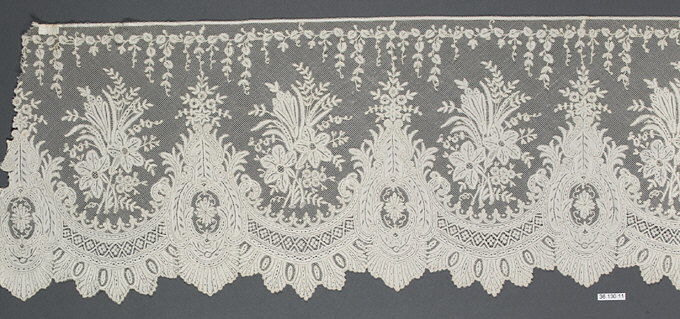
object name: border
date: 1860-1870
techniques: lace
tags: flowers